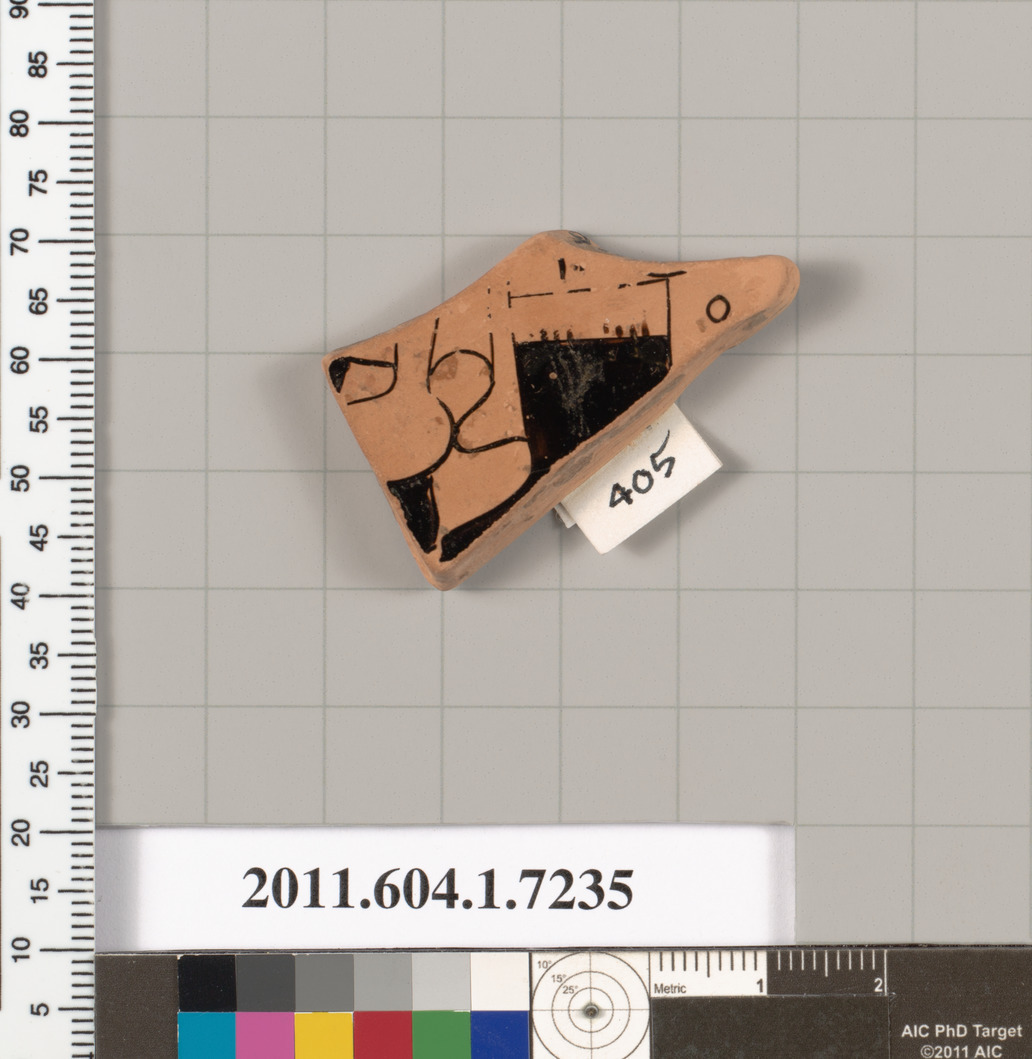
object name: kylix fragment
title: Terracotta fragment of a kylix (drinking cup)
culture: greek, attic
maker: makron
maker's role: artist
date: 500-480 BCE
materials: terracotta